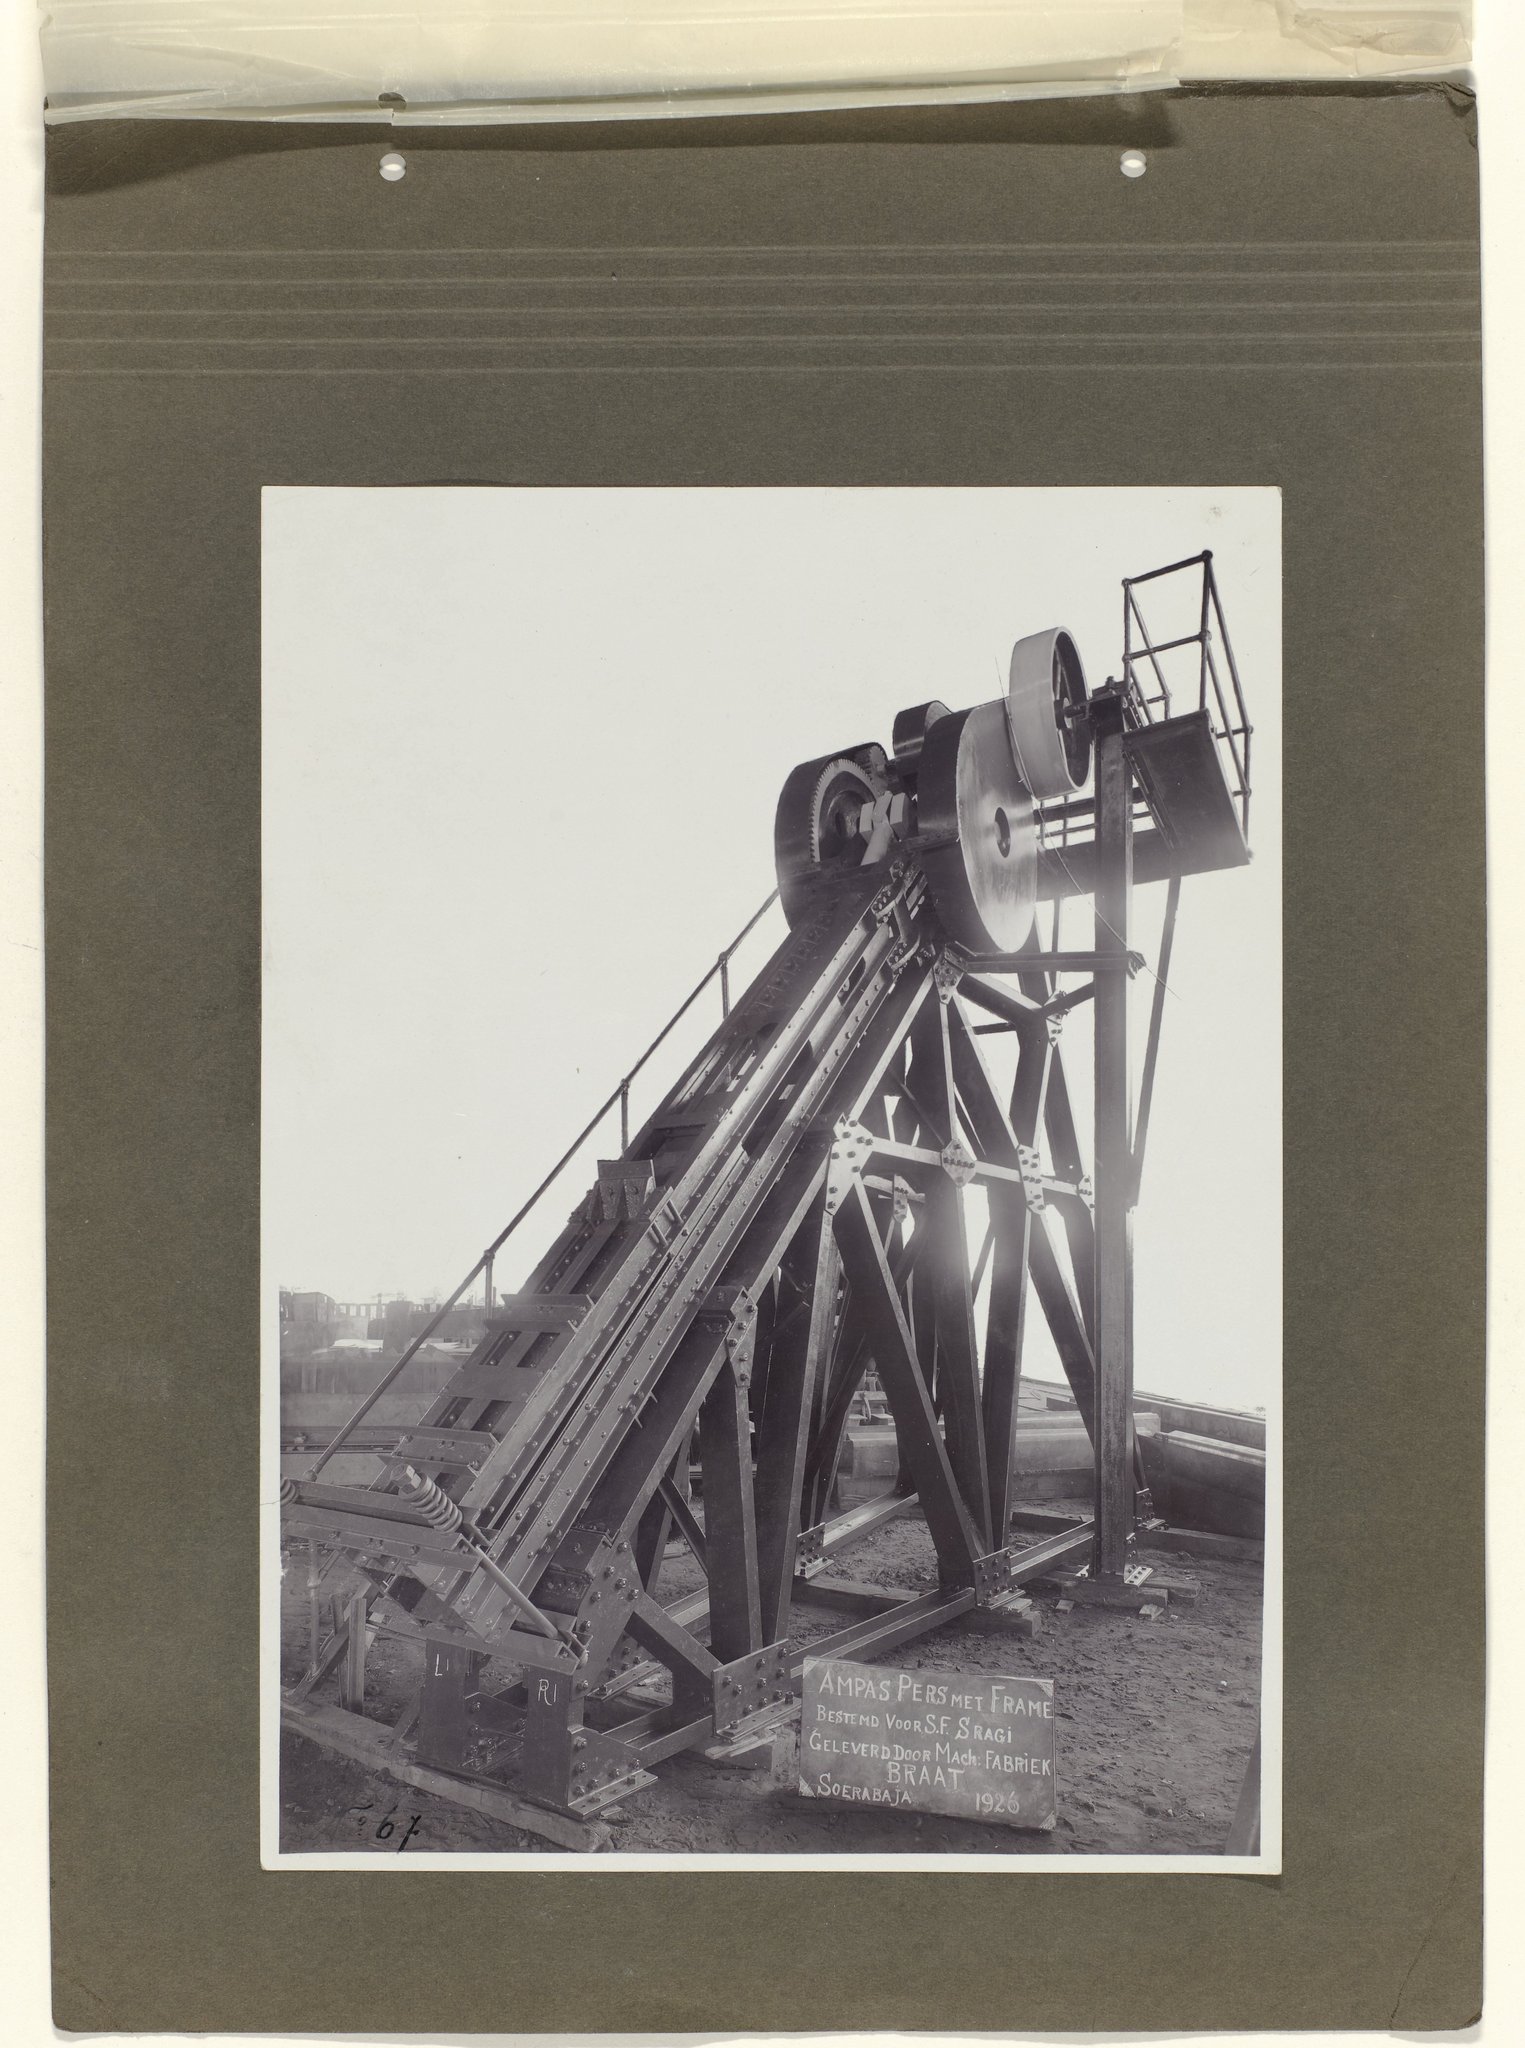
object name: photograph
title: Ampas pers met frame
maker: Anonymous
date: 1926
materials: cardboard, photographic support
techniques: gelatin silver print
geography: surabaya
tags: colonial system, factory-interior, machine shop, machines; parts of machines; tools and appliances, (non-fruit) products of plants or trees: sugarcane, java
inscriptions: date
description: Ampas pers met frame, vervaardigd in 1926 en bestemd voor de Suikerfabriek Sragi op Oost-Java. Foto geplakt op een los albumblad. Onderdeel van een groep van losse, grotere foto's van verschillende soorten machines van de N.V. Machinefabriek Braat te Soerabaja, uit de periode ca. 1920-1940.